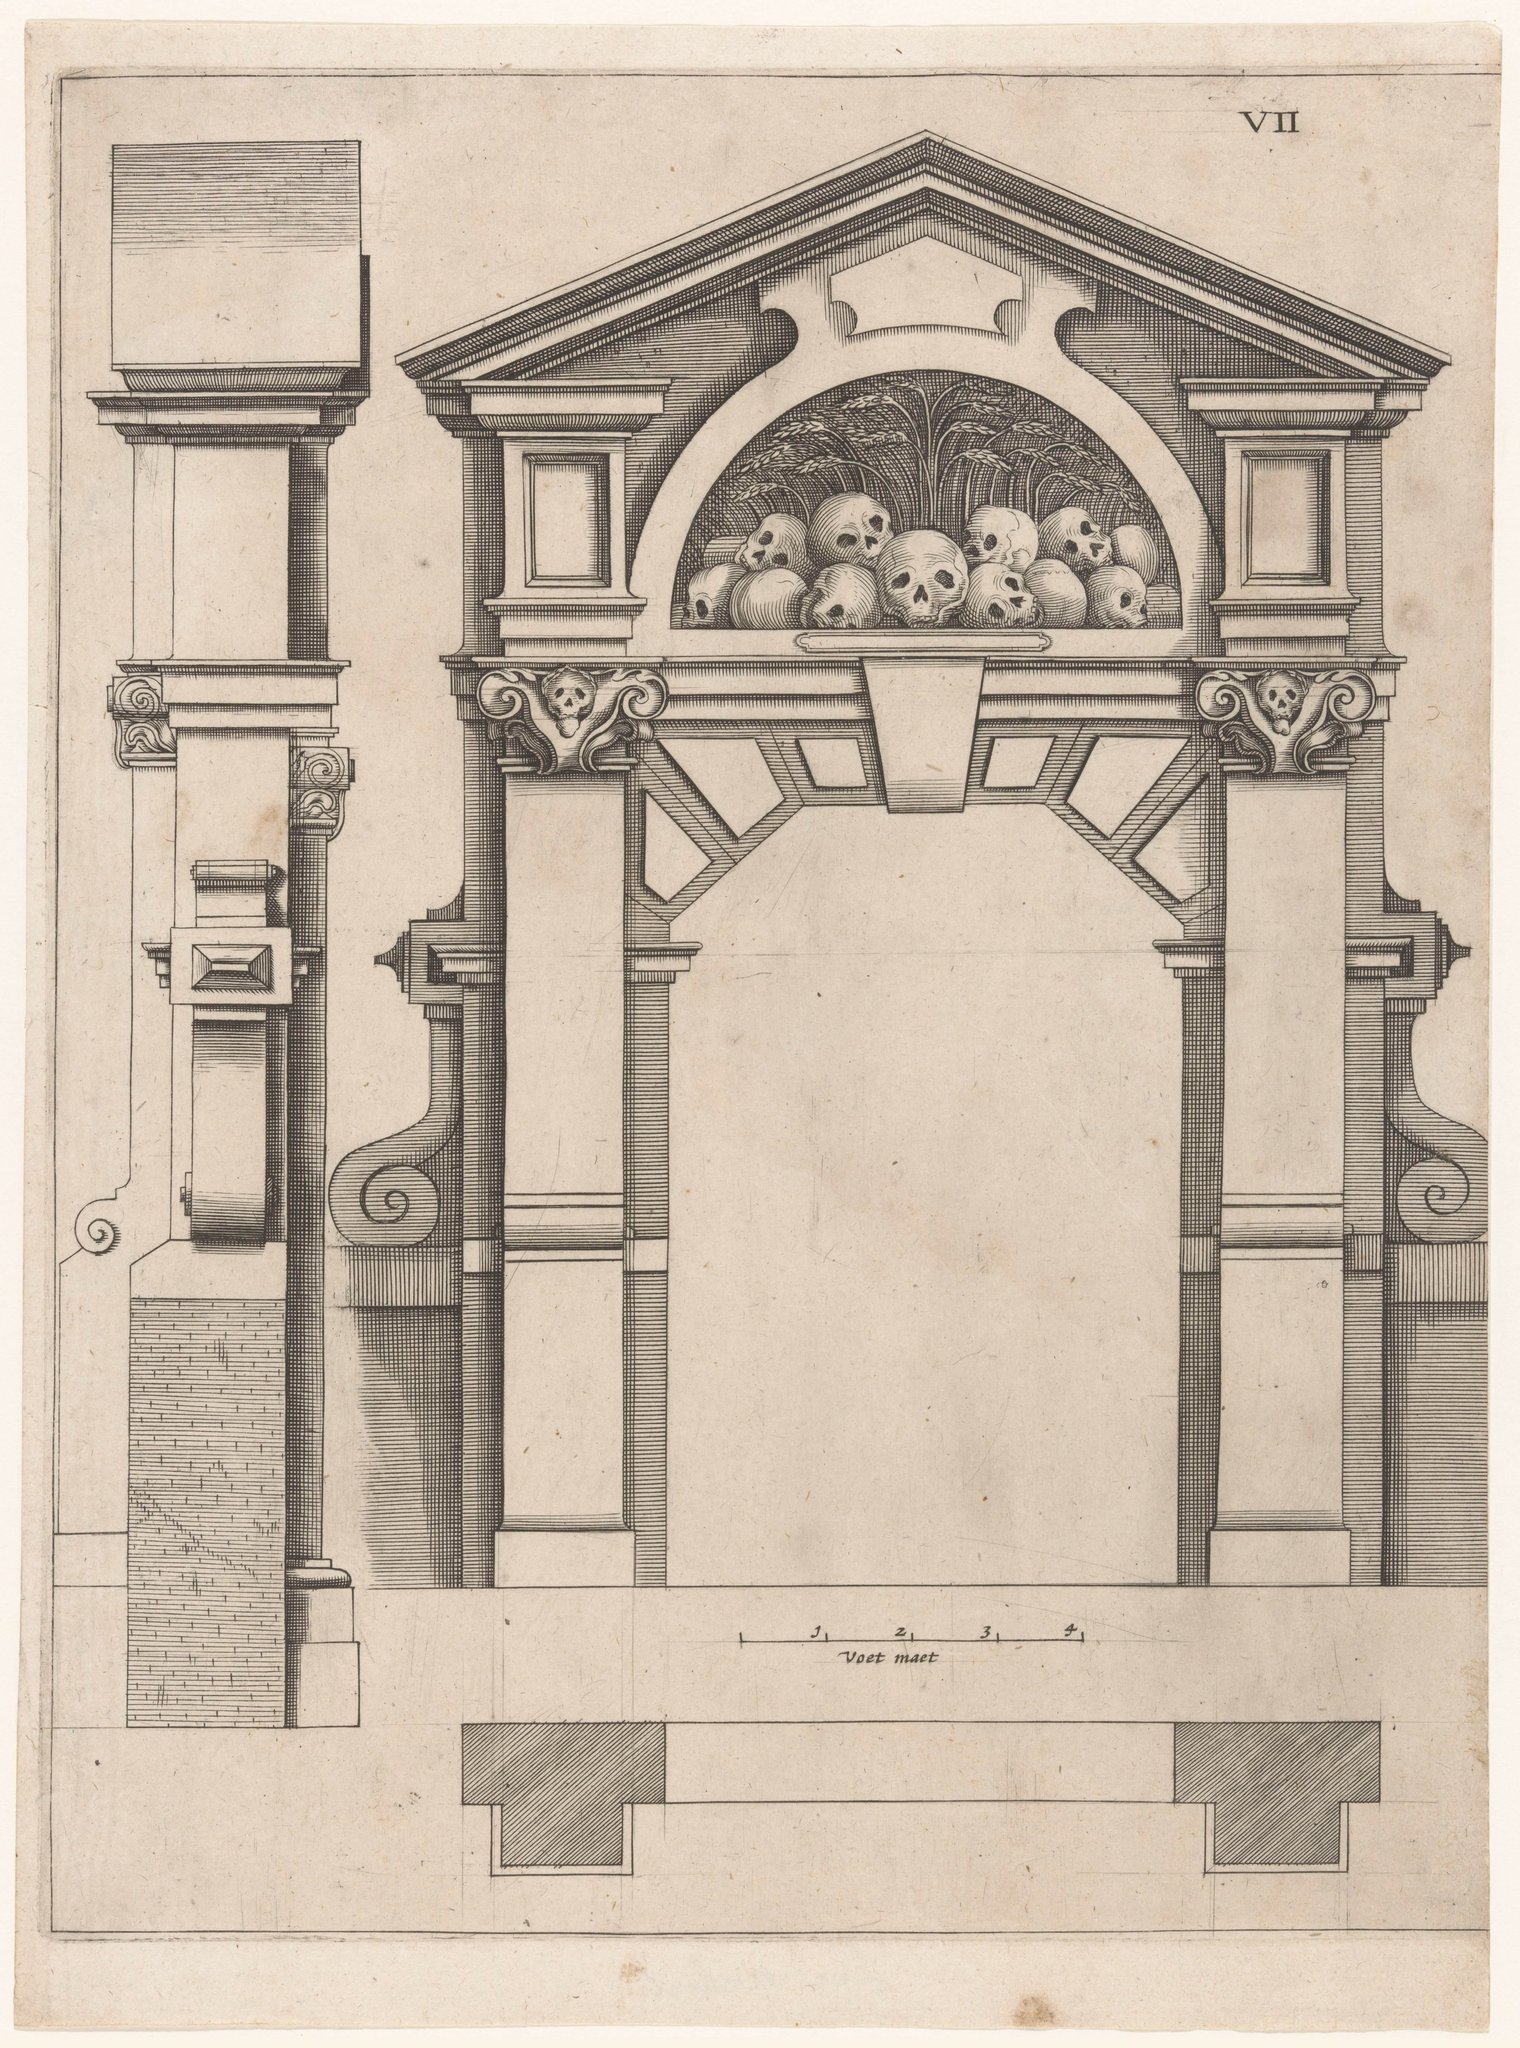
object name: ornament print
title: Poort tot begraafplaats bij de Zuiderkerk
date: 1631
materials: paper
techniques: engraving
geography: amsterdam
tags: churchyard, cemetery, plan ~ architecture, exterior ~ architectural design or model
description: Prent uit: Keyser, Hendrick de. Architectura moderna ofte bouwinge van onsen tyt (...) alle gedaen by (...) Amsterdam: Danckerts, Cornelis, 1631.